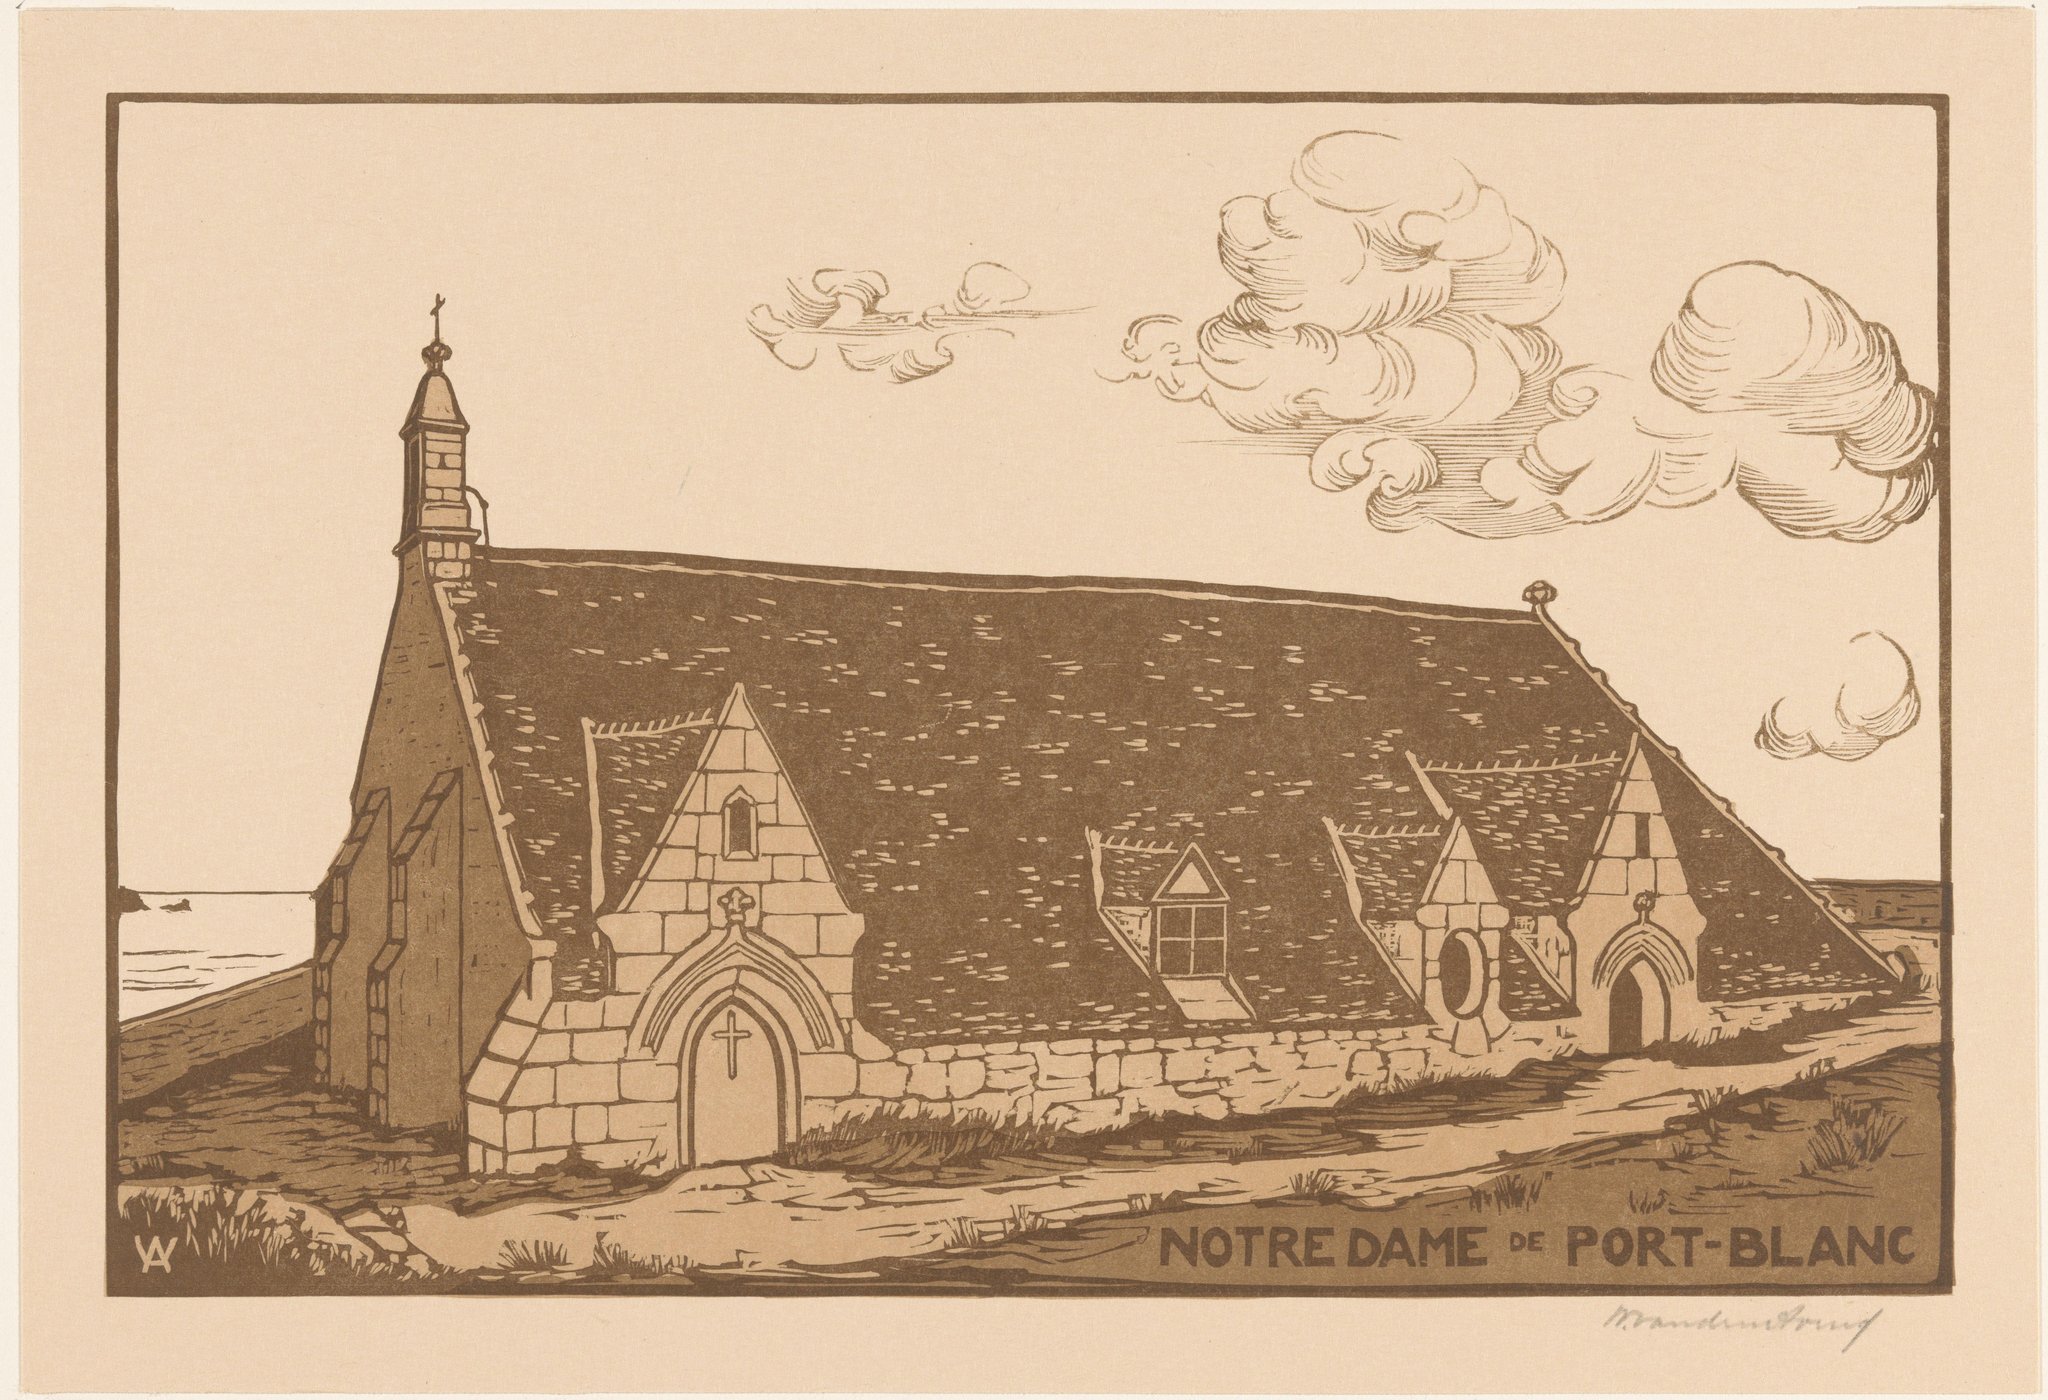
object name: print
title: Notre-Dame de Pont-Blanc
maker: willem van den arend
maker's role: painter, print maker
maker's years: 1875-1954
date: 1885-1930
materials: paper, ink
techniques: woodcut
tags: bretagne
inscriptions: title: ‘NOTRE DAME DE PORT-BLANC’, monogram: ‘WA’, signature: ‘W. vandenArend’, collector's mark: Lugt 2228